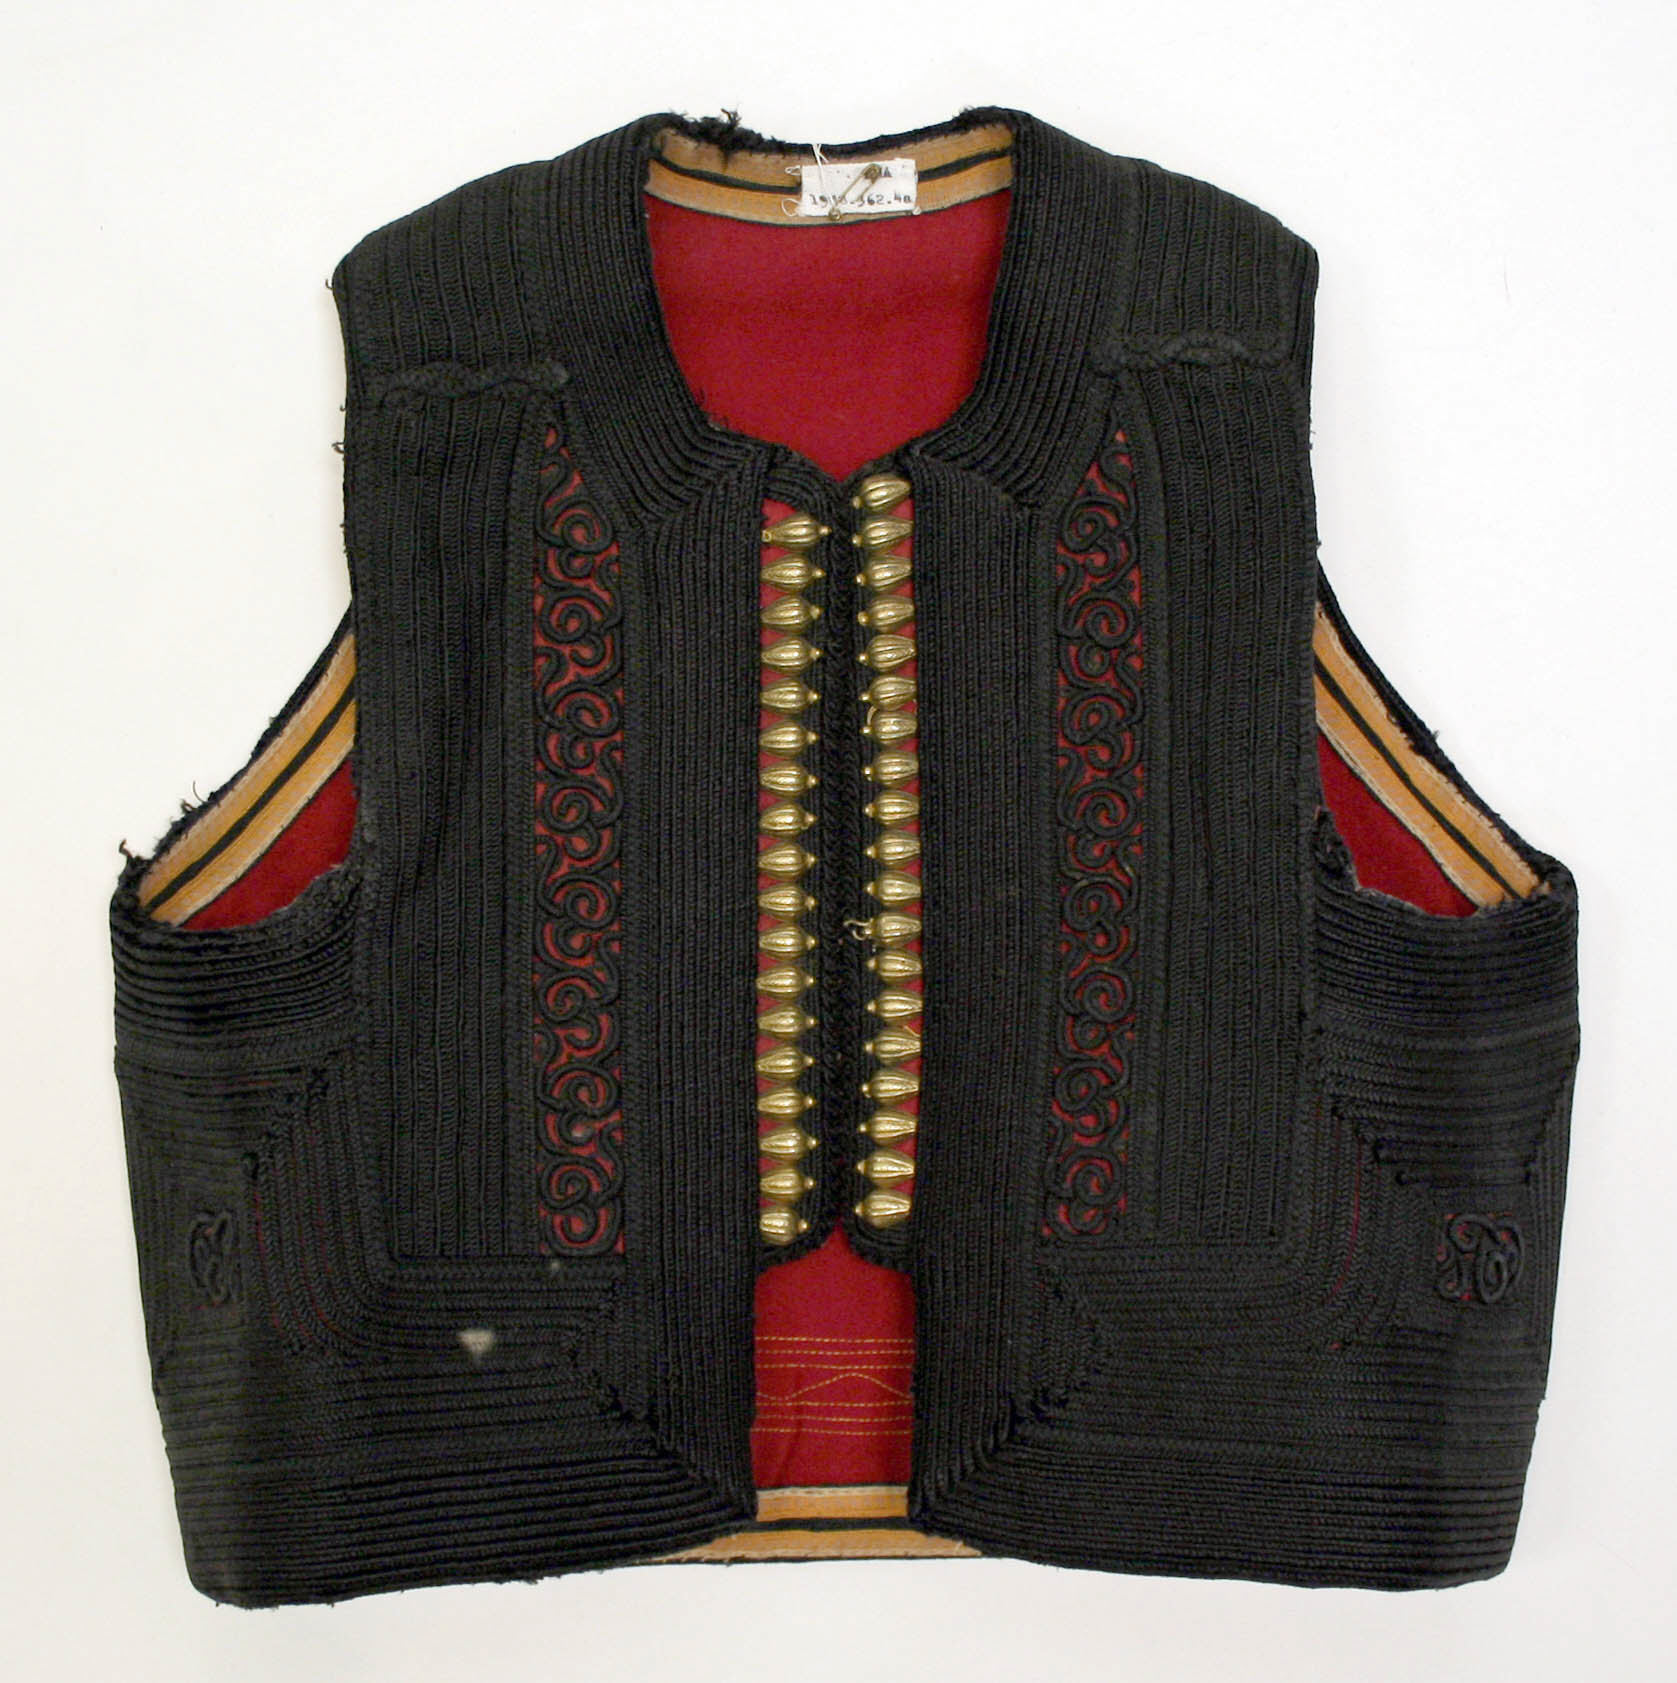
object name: ensemble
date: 1867-1933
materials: cotton, leather, metal, silk, wool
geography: northern